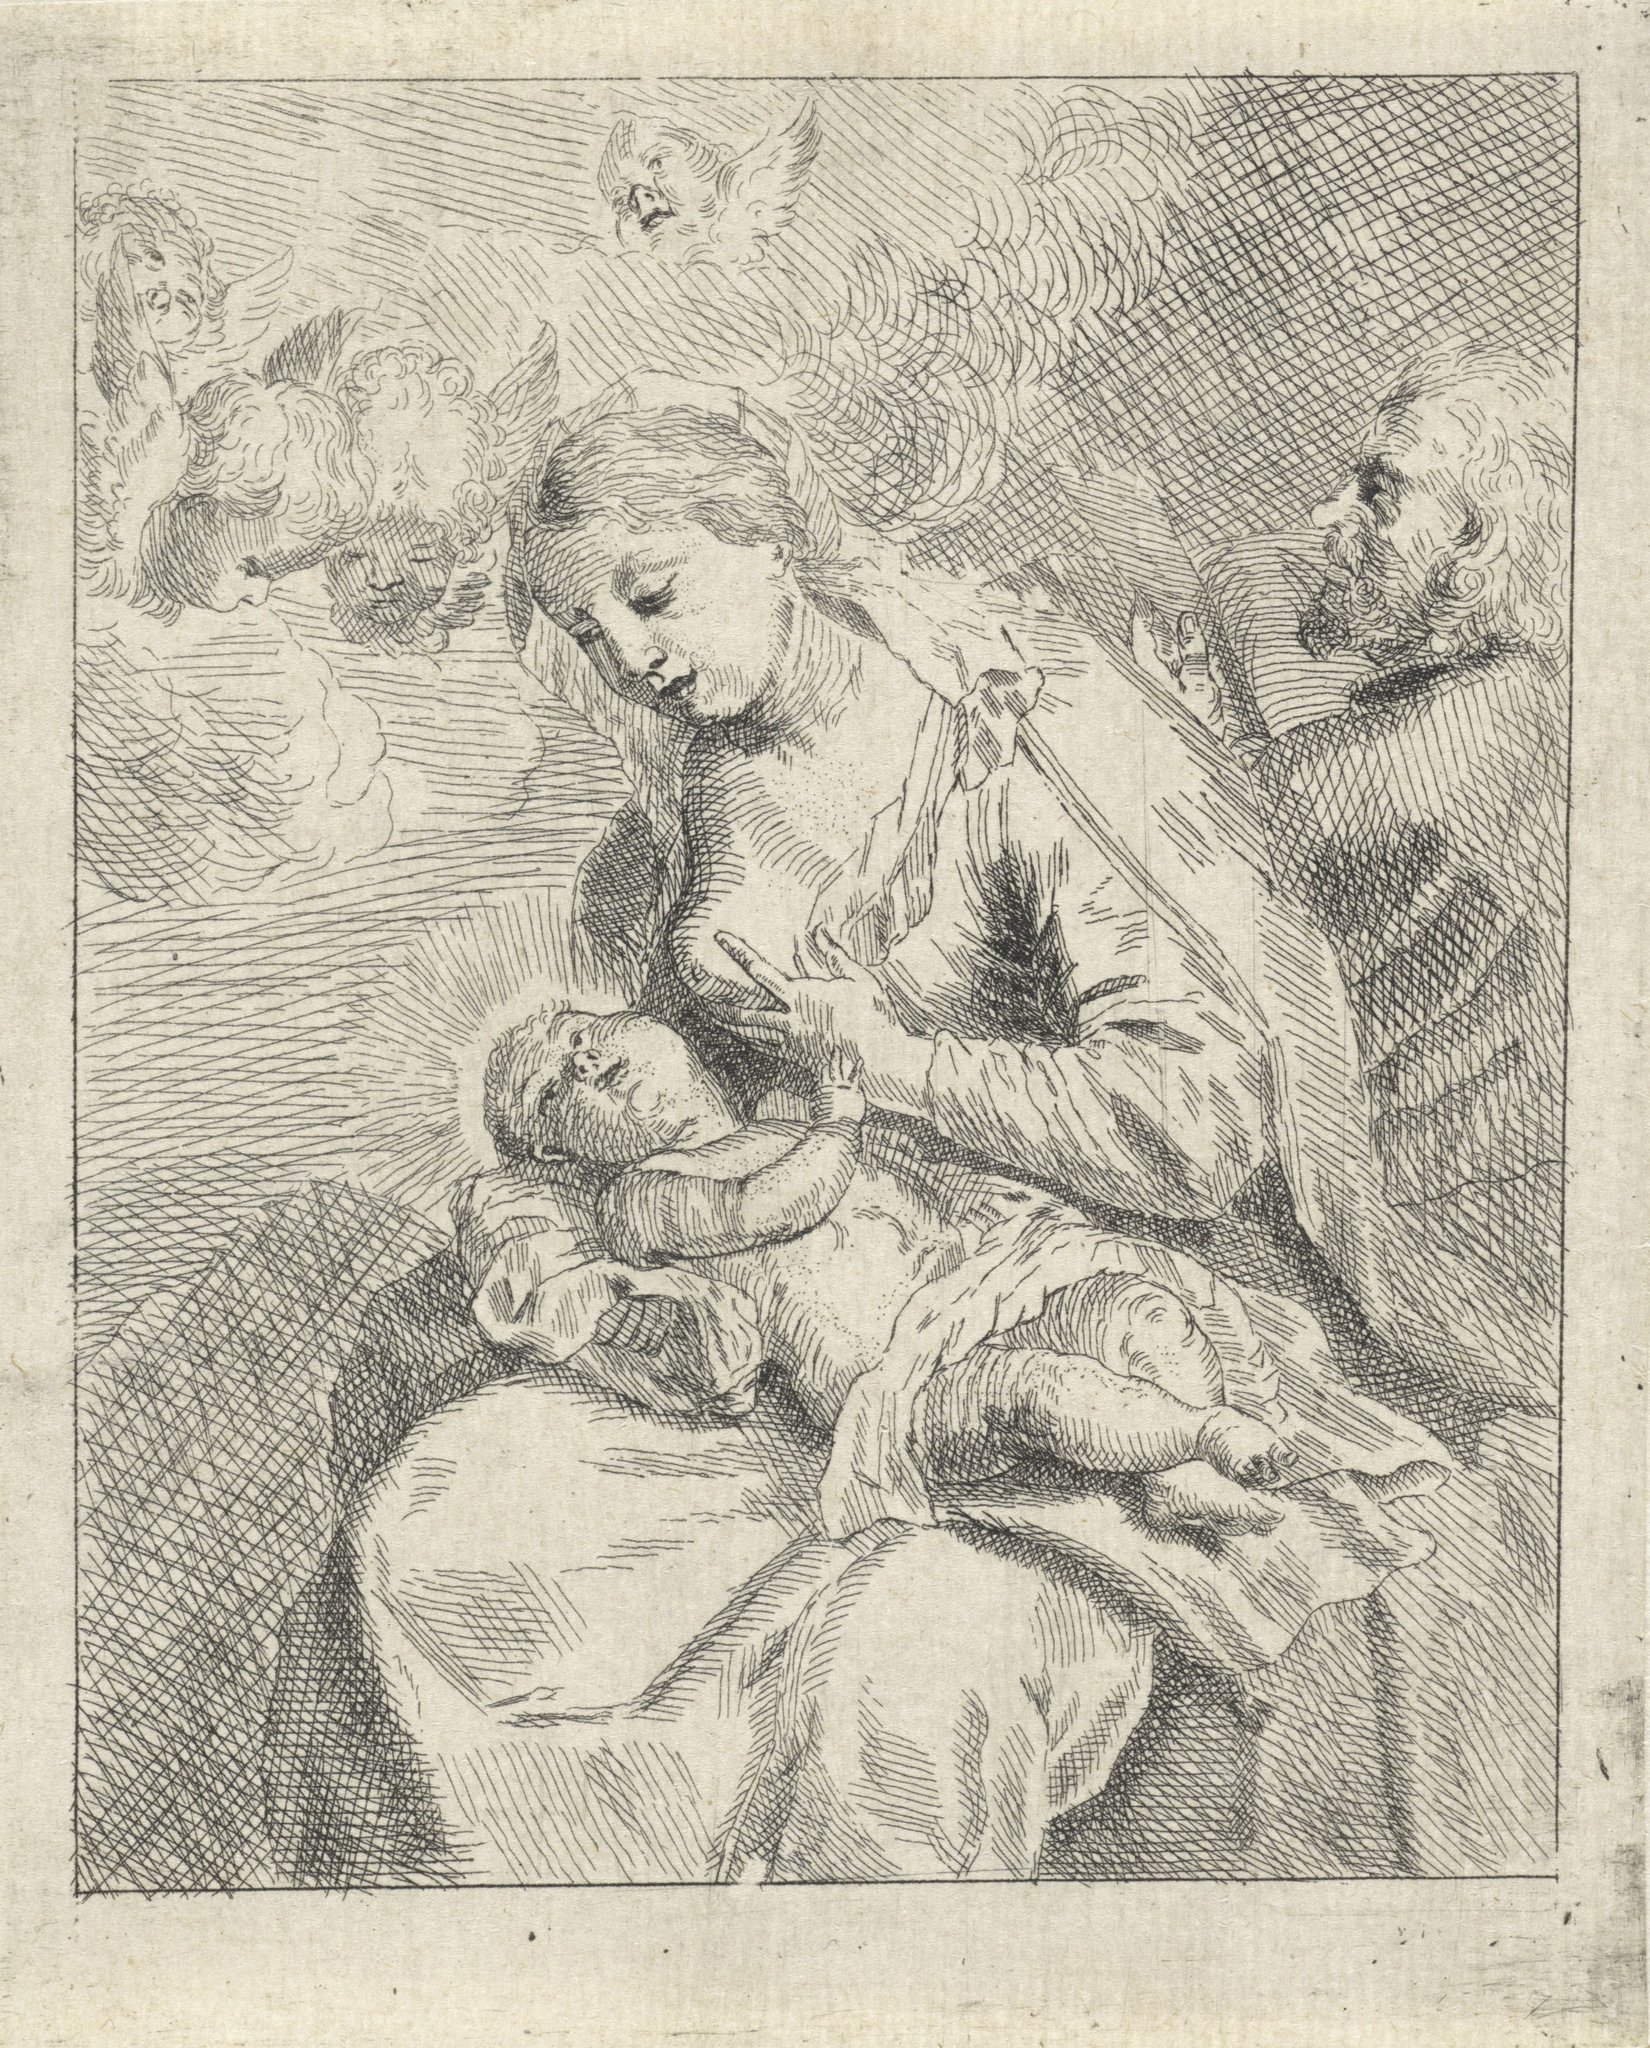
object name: print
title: Maria zoogt het Christuskind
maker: Anonymous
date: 1615-1691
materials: paper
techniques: etching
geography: low countries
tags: cherubs, i.e. children's heads with wings, 'ablactatio'; christ not drinking, mary's breast bare ~ madonna-representations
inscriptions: collector's mark: Lugt 240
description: Het Christuskind ligt op schoot bij Maria. Zij houdt haar ontblote borst vast. Achter haar zit een Jozef met een opengeslagen boek. Linksboven enkele Cherubijnen.